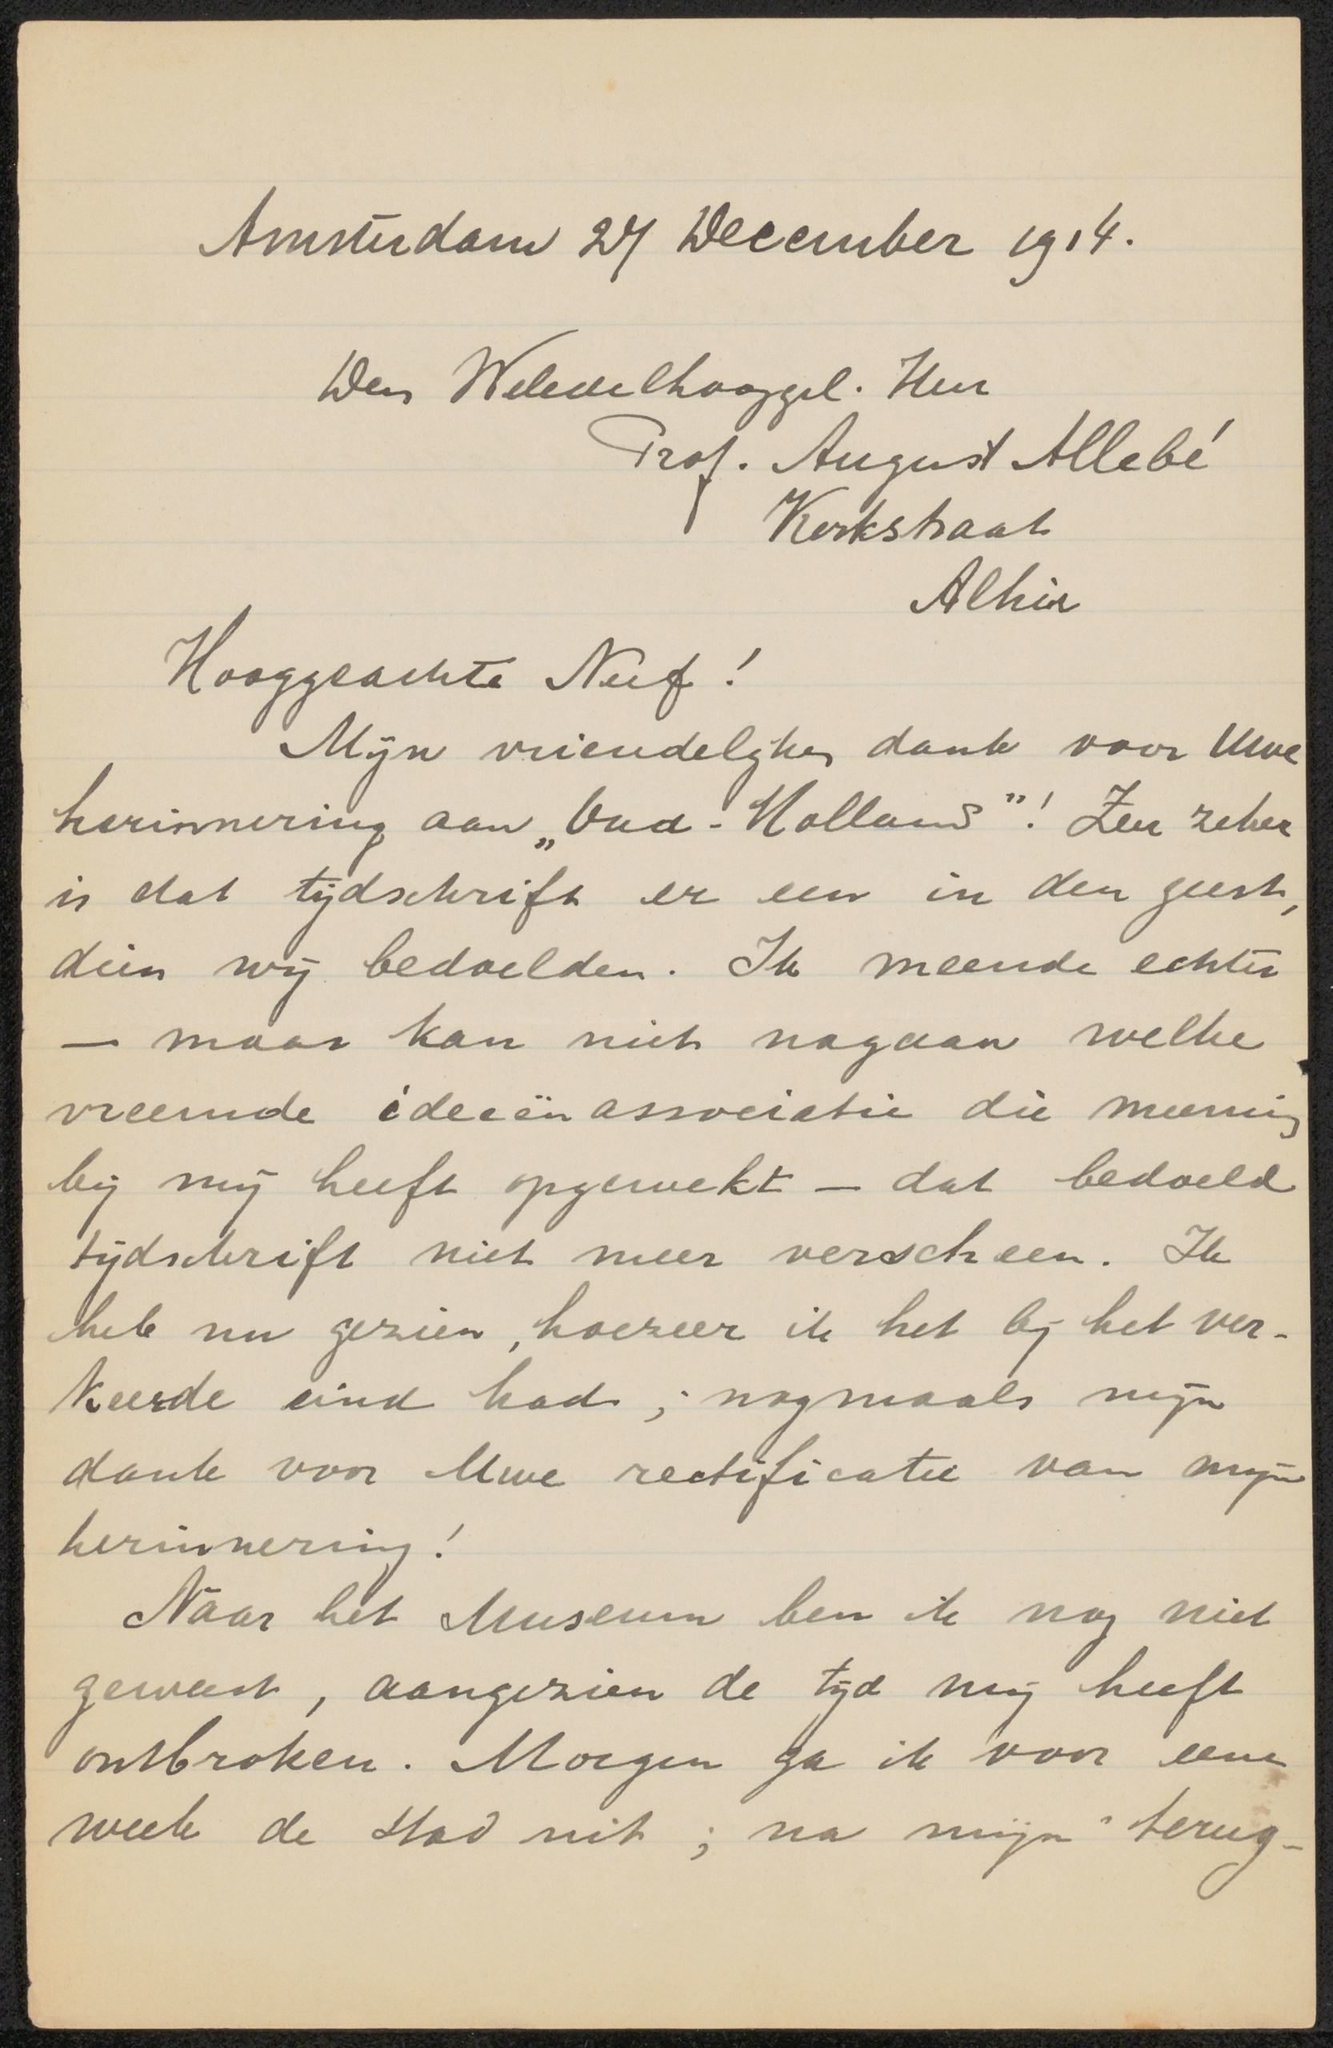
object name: letter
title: Brief aan August Allebé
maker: a.j. d ailly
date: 1914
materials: ink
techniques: pen, writing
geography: amsterdam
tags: amsterdam, print maker, draughtsman, august allebé